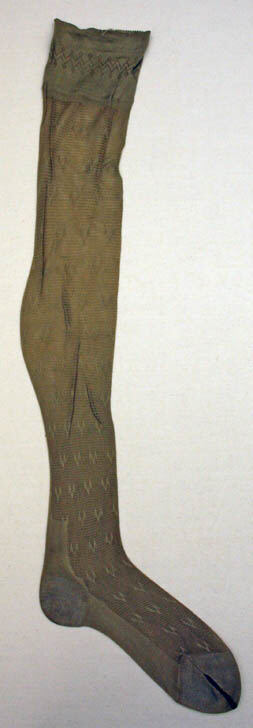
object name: stocking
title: Stockings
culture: american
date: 1890